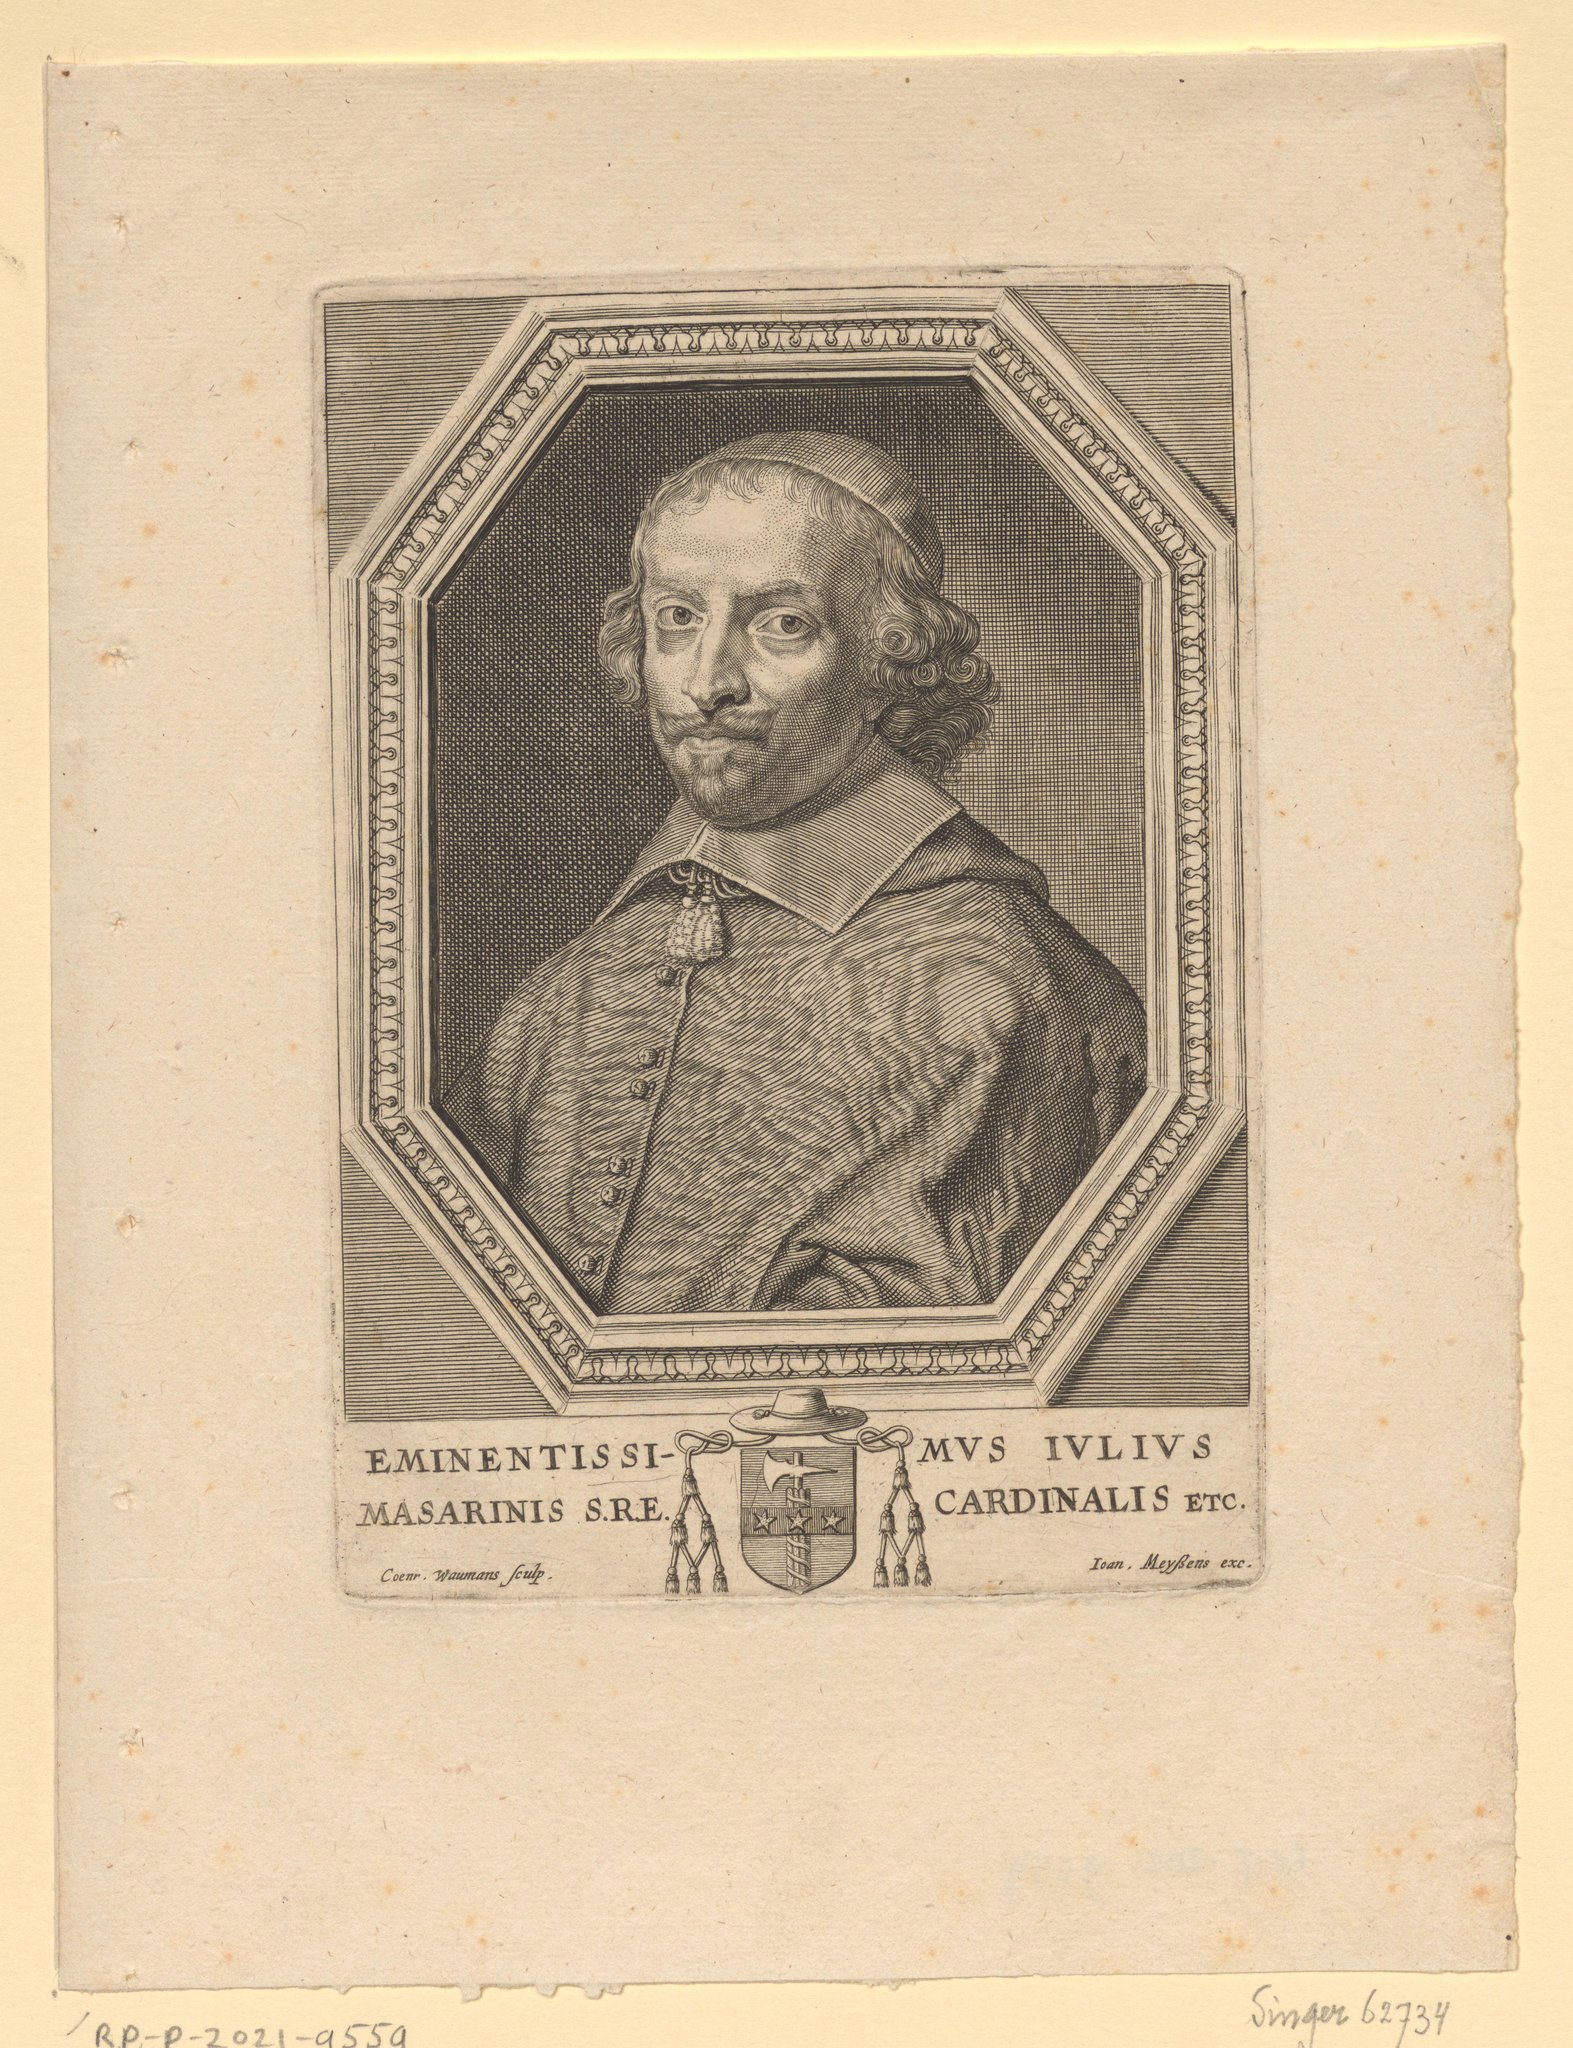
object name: print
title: Portret van Jules Mazarin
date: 1641-1670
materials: paper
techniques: engraving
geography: antwerp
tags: jules mazarin, coat of arms (symbol of sovereignty), cardinal, historical persons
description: Met tweeregelig onderschrift in het Latijn.